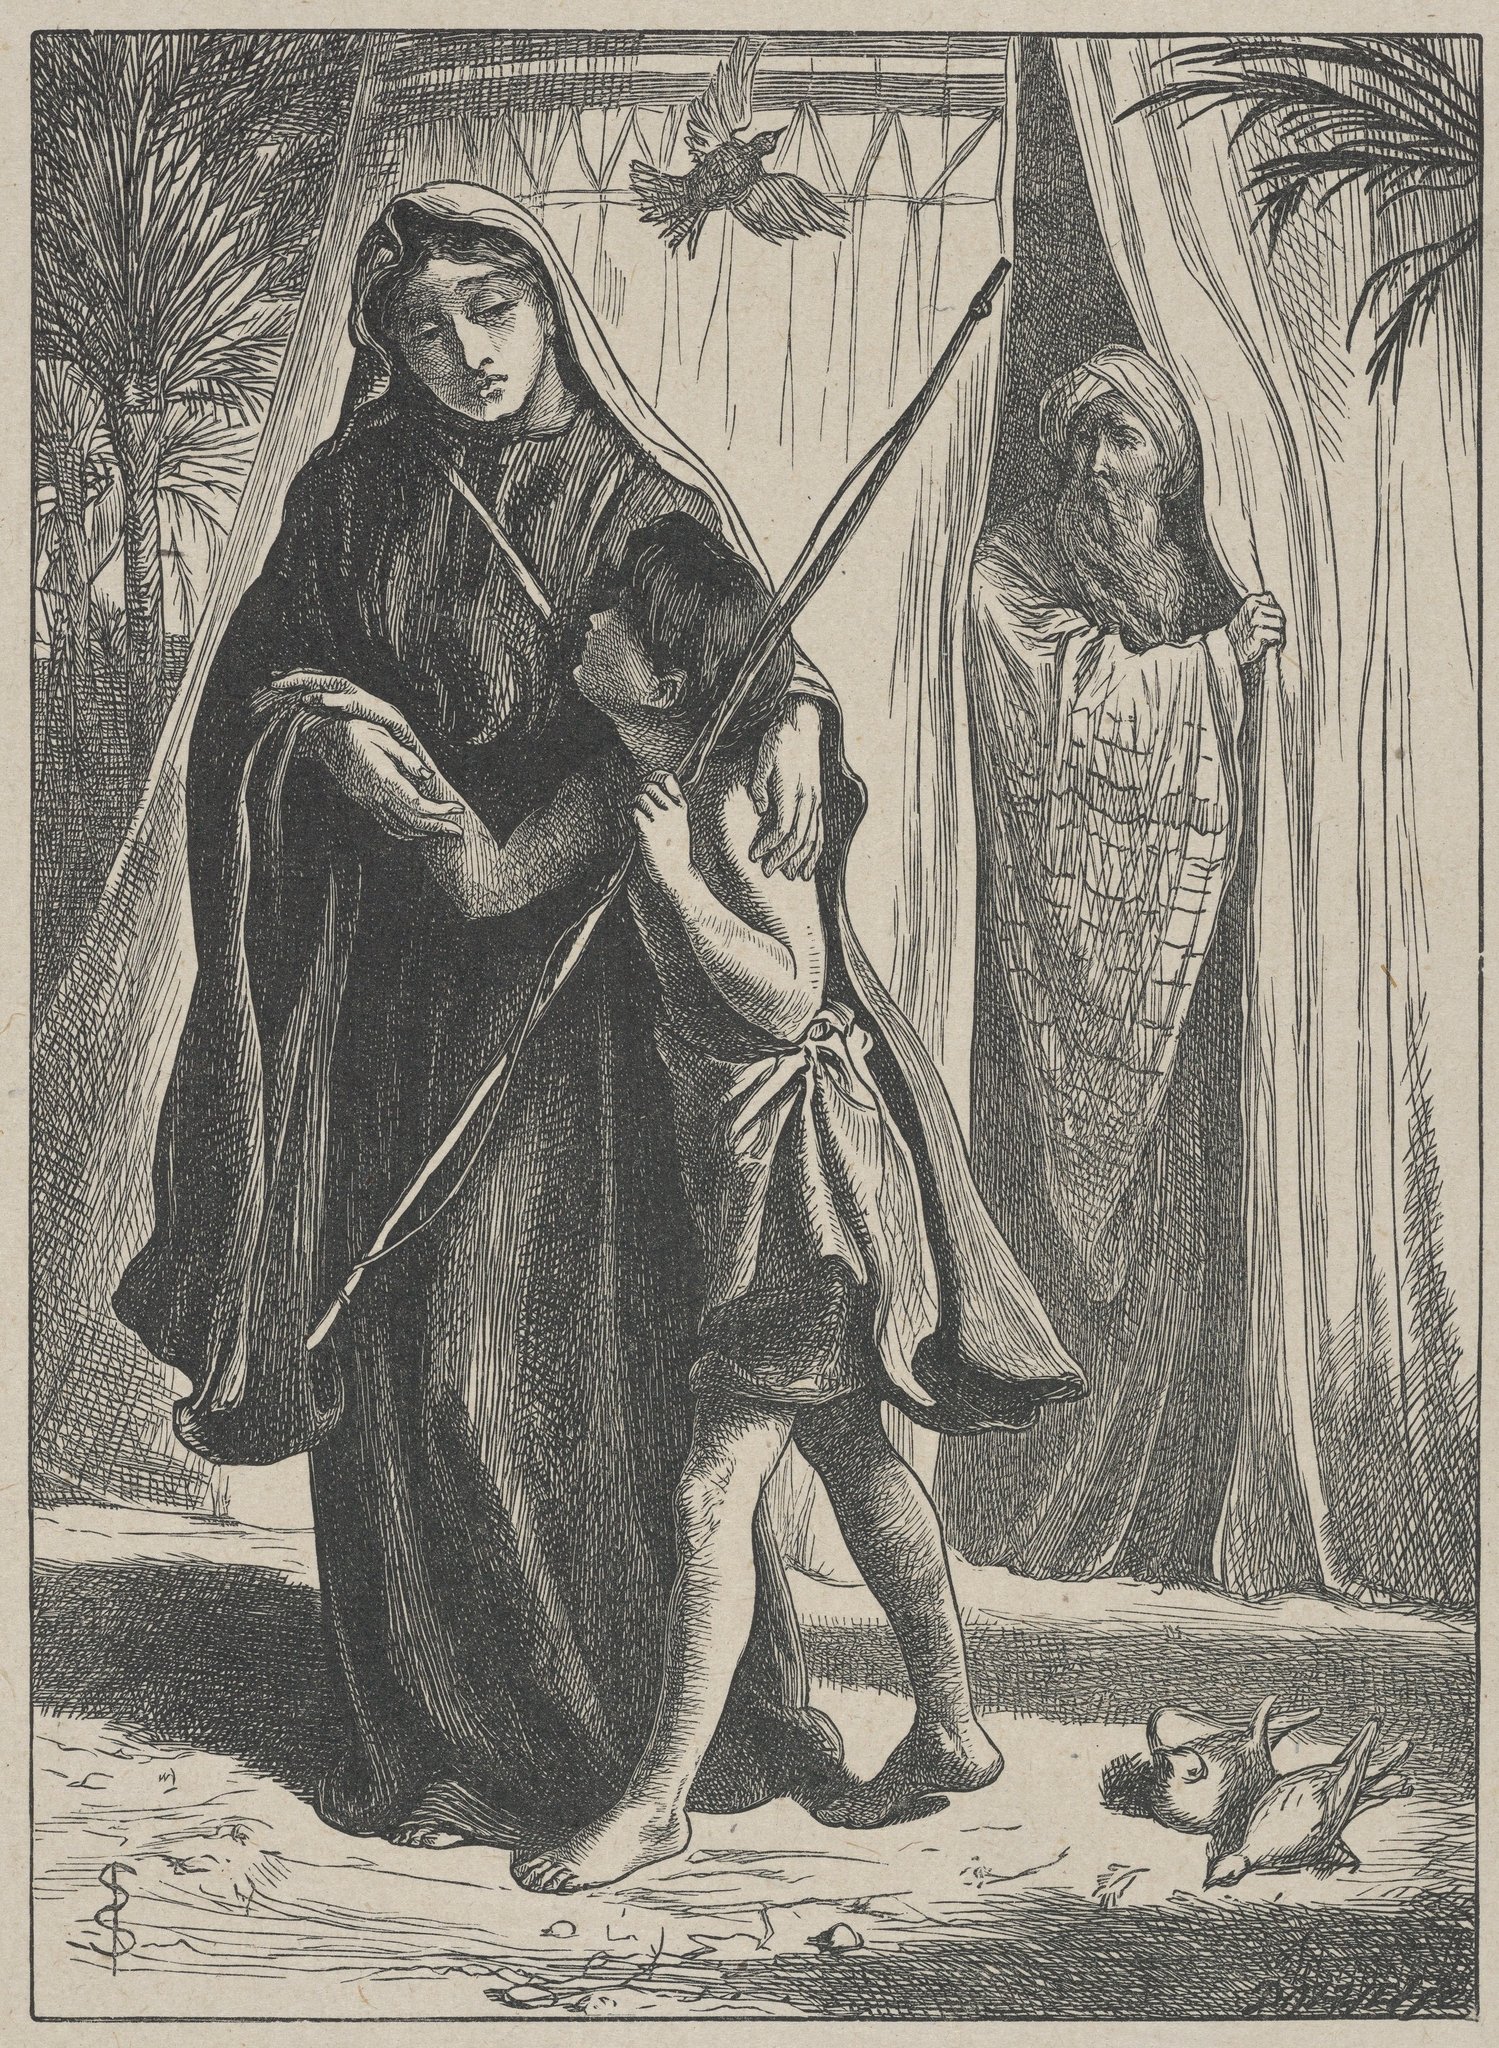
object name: print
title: Hagar and Ishmael, from "Dalziels' Bible Gallery"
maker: simeon solomon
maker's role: artist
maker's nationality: british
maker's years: 1840-1905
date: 1863-1881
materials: paper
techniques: engraving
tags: boys,men,women